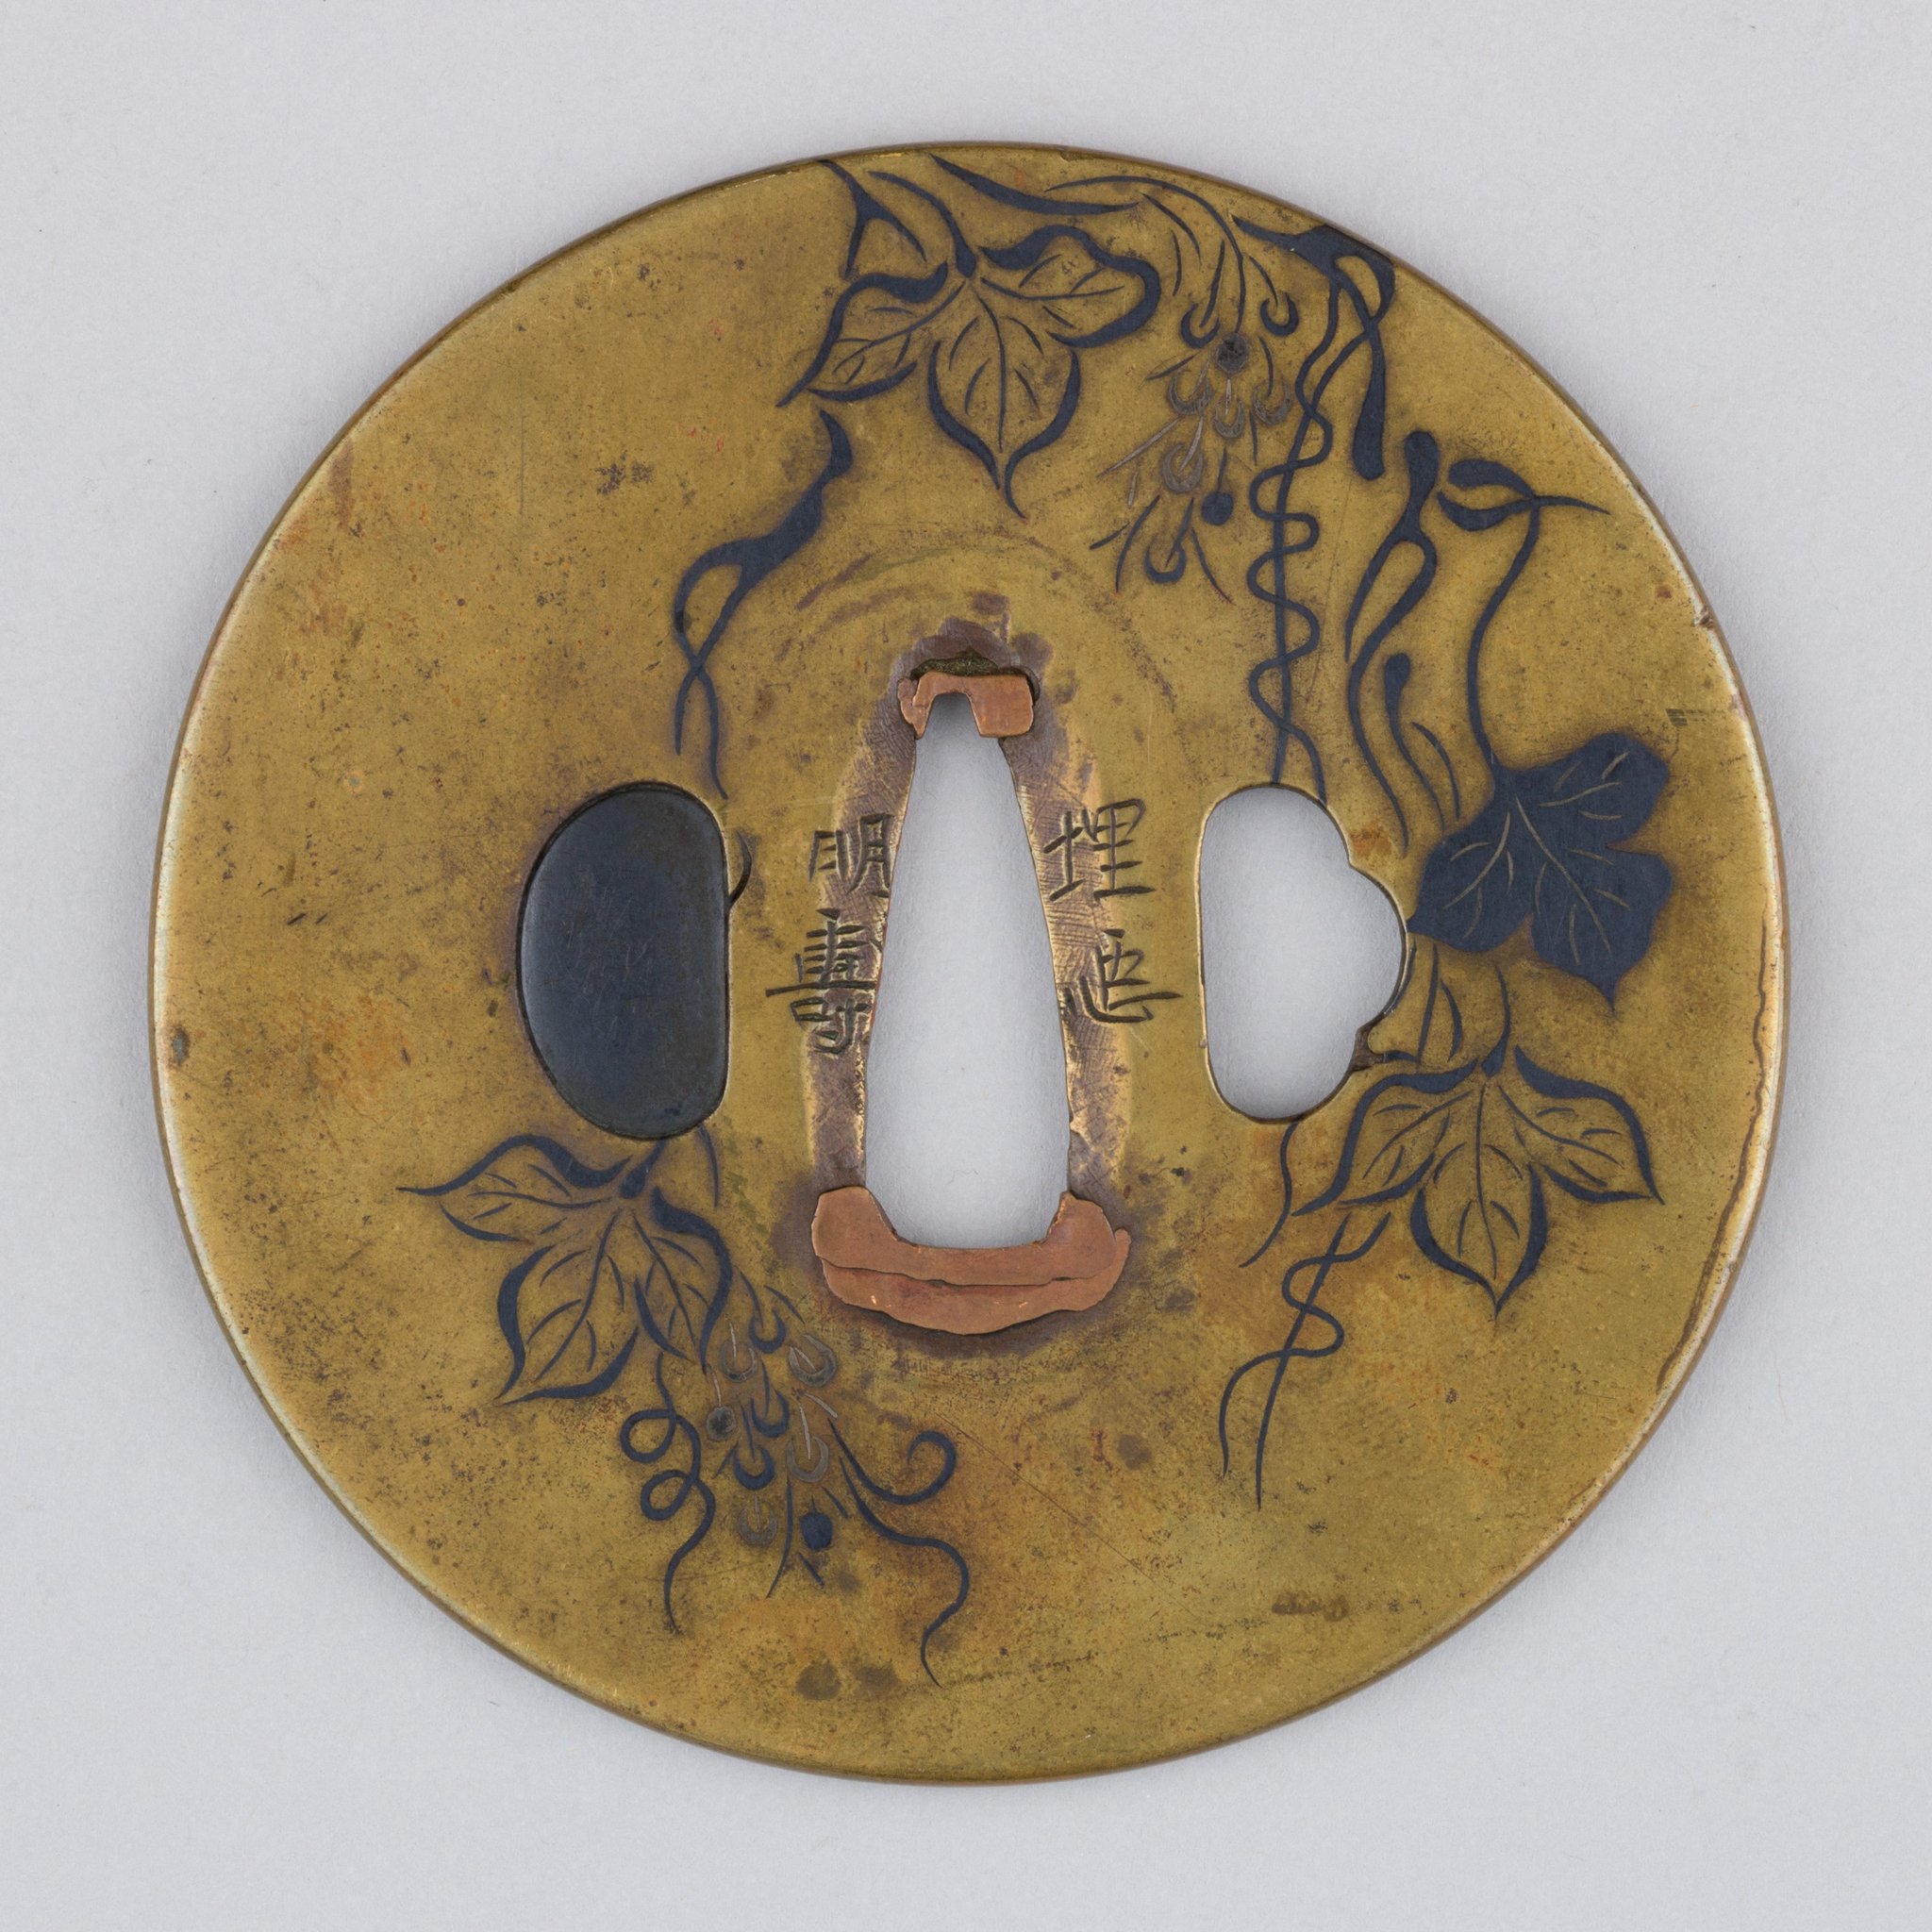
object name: sword guard tsuba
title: Sword Guard (Tsuba)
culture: japanese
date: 1601-1700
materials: copper, copper alloy, gold alloy, silver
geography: japan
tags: leaves